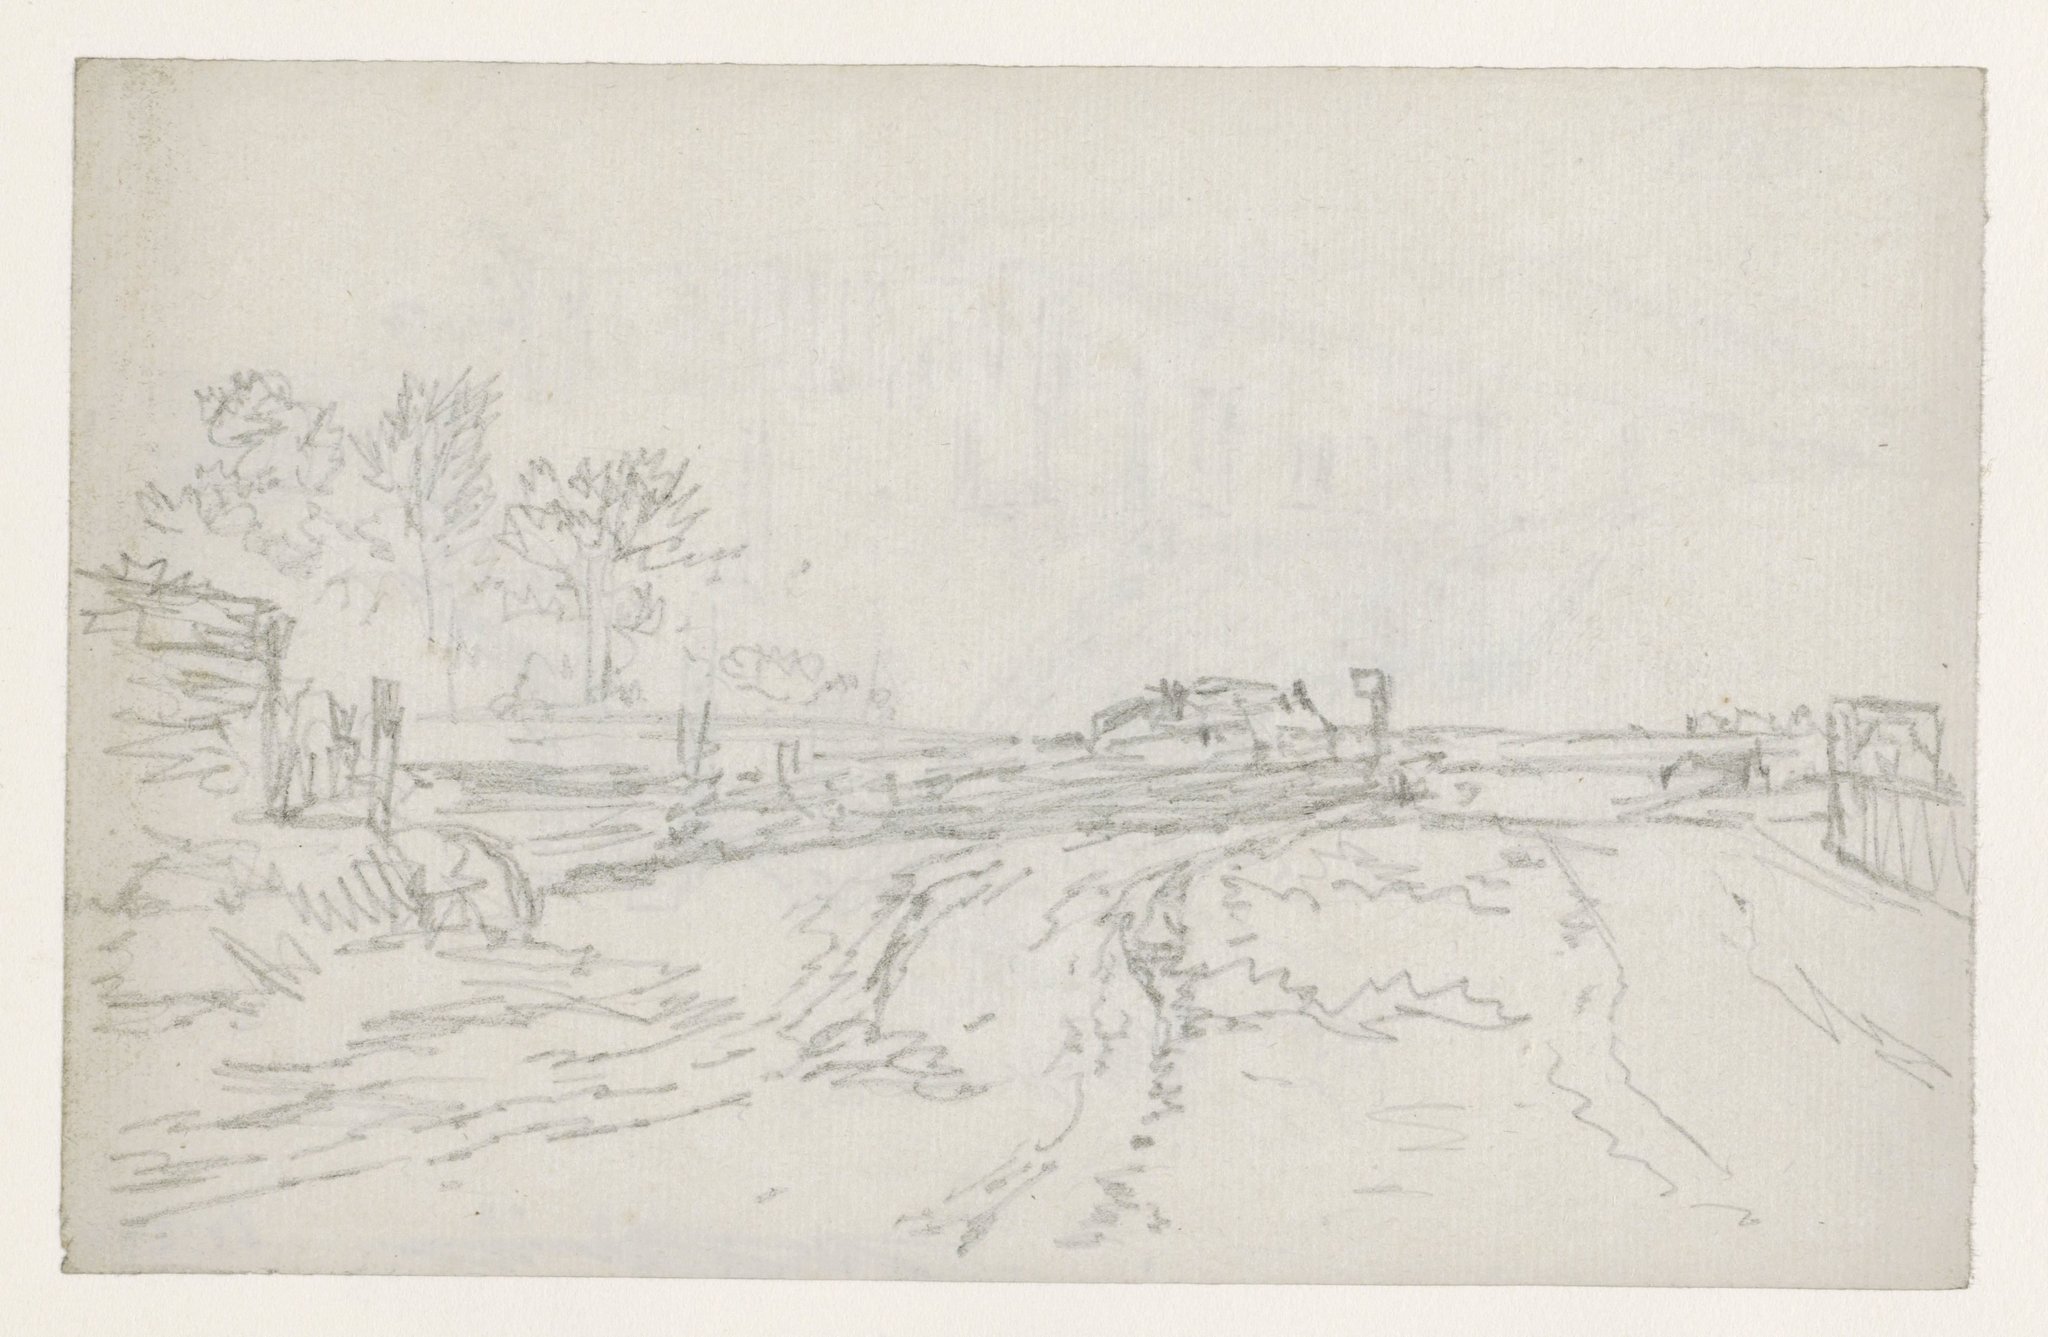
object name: drawing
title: Zandige weg met enkele boerderijen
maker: georges michel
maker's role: draughtsman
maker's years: 1763-1843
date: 1773-1843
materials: paper, pencil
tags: public road in village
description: Een van 120 tekeningen, afkomstig uit een 19e eeuws album met tekeningen van Georges Michel.